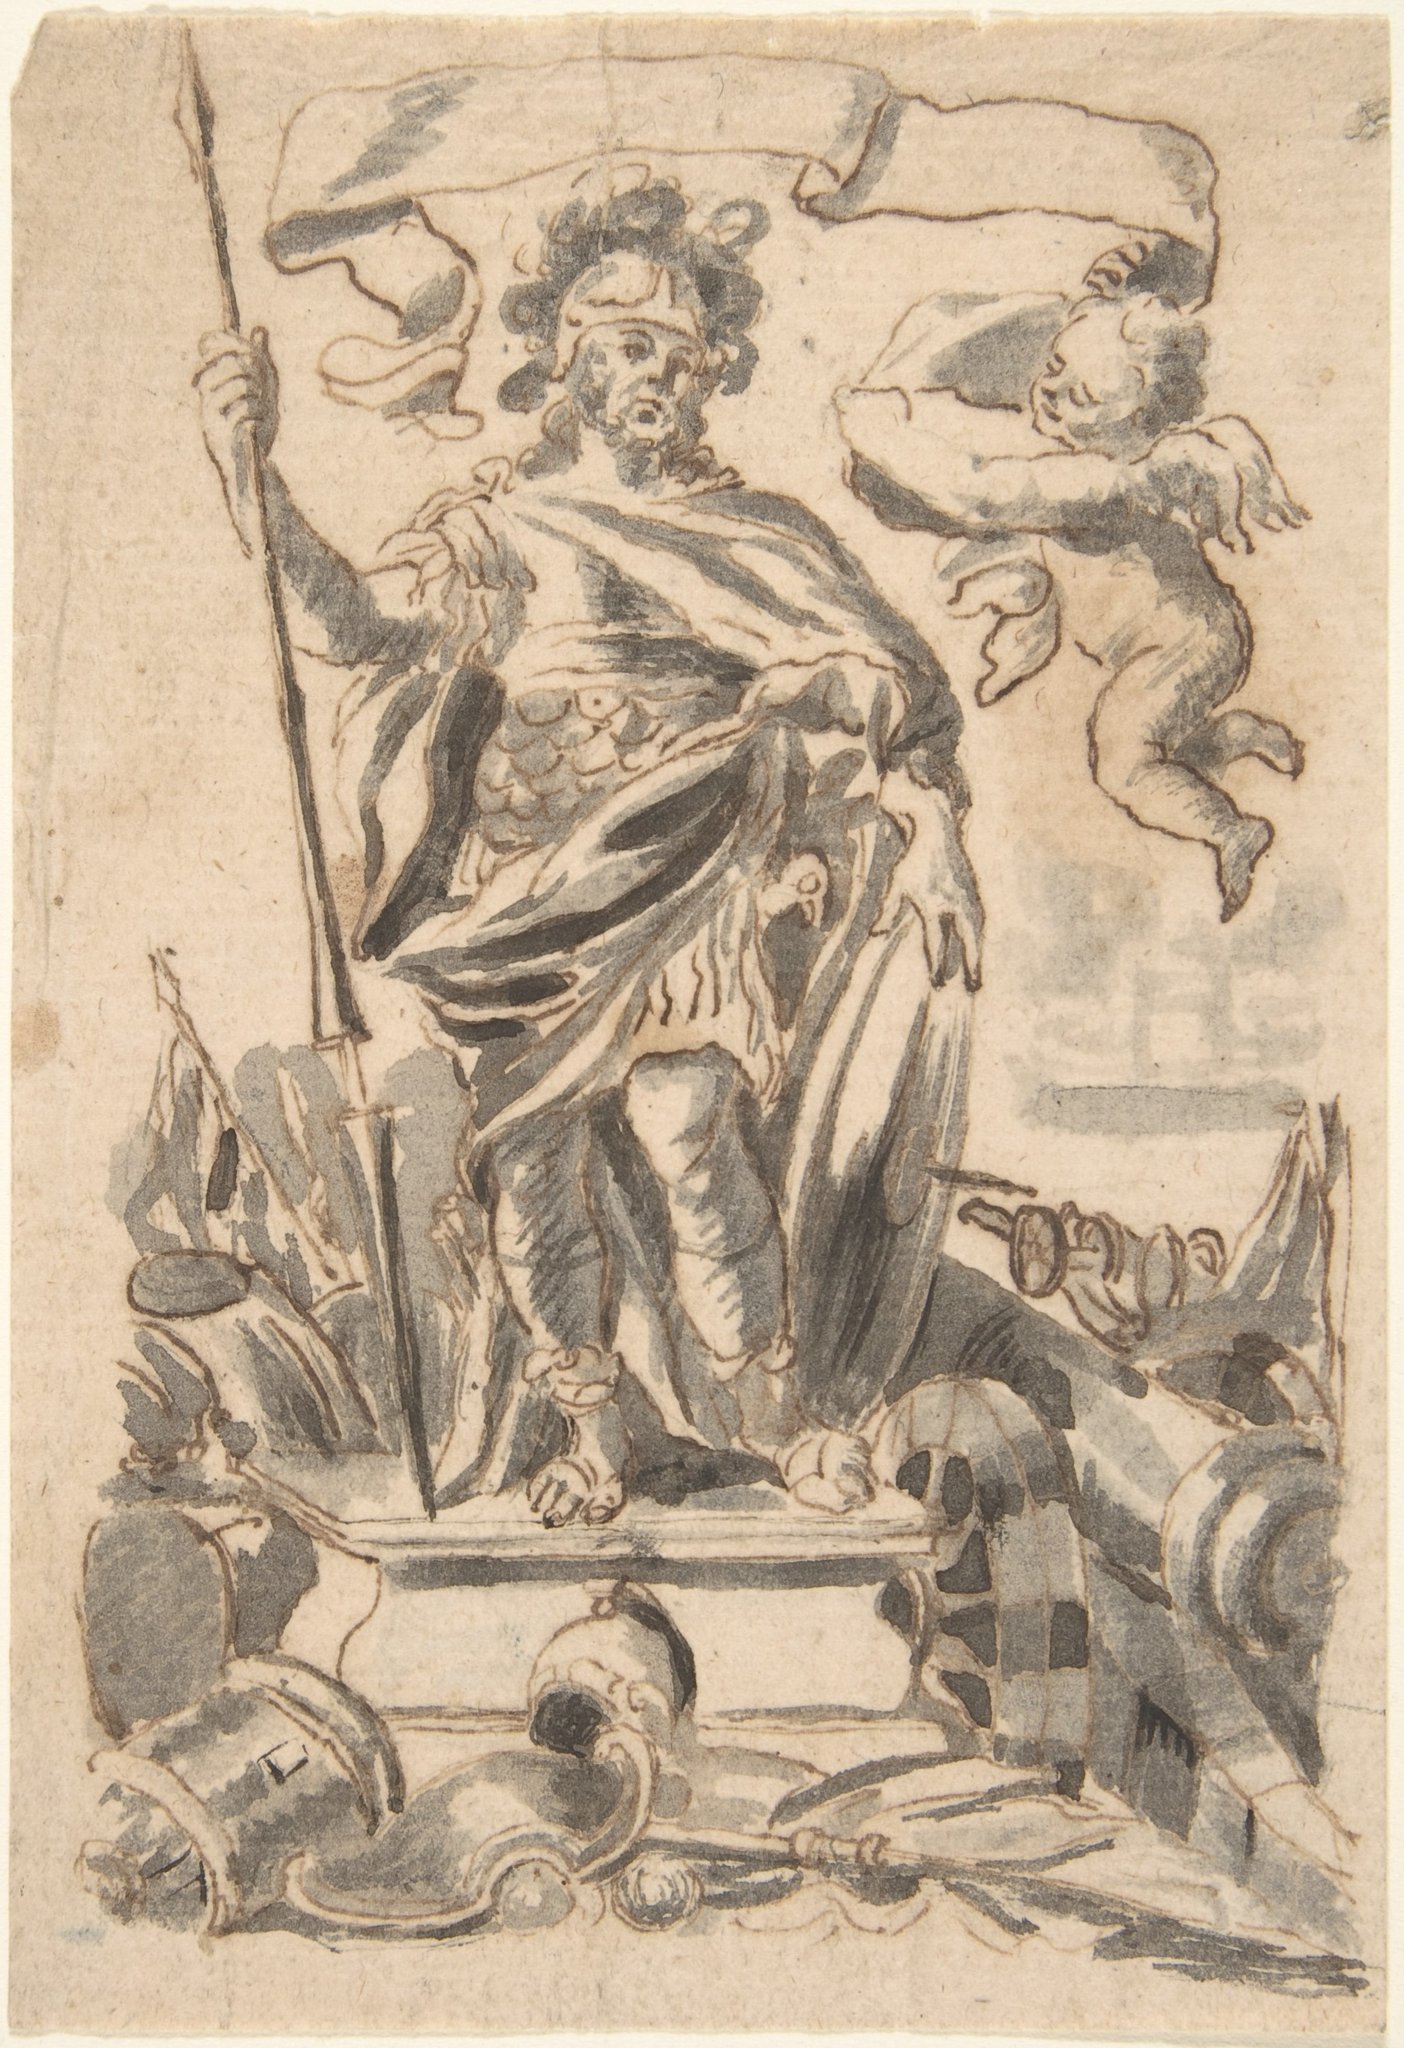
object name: drawing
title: Design for a Book Illustration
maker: william faithorne the elder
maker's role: artist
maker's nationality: british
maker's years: 1615-1691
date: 1601-1700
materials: graphite, ink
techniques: brush, pen, wash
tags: men,flags